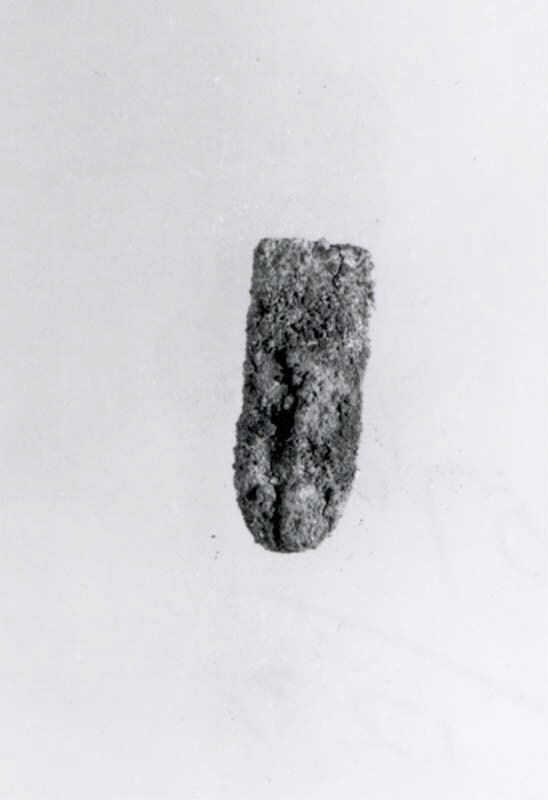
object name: armor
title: Armor plate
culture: assyrian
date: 734-601 BCE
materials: iron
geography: mesopotamia